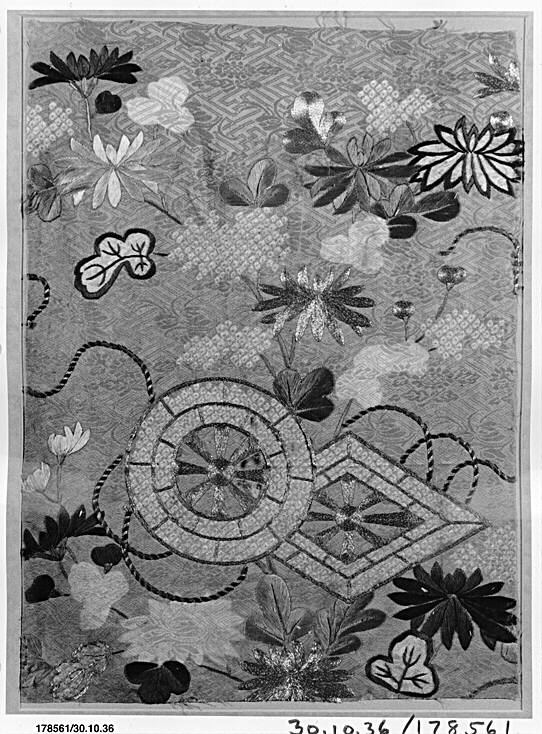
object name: piece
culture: japanese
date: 1801-1900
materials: metal thread, silk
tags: flowers